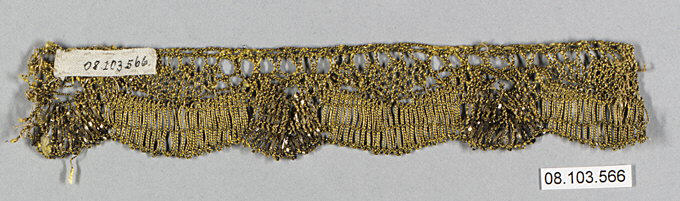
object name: piece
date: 1701-1800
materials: metal thread, silk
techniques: lace